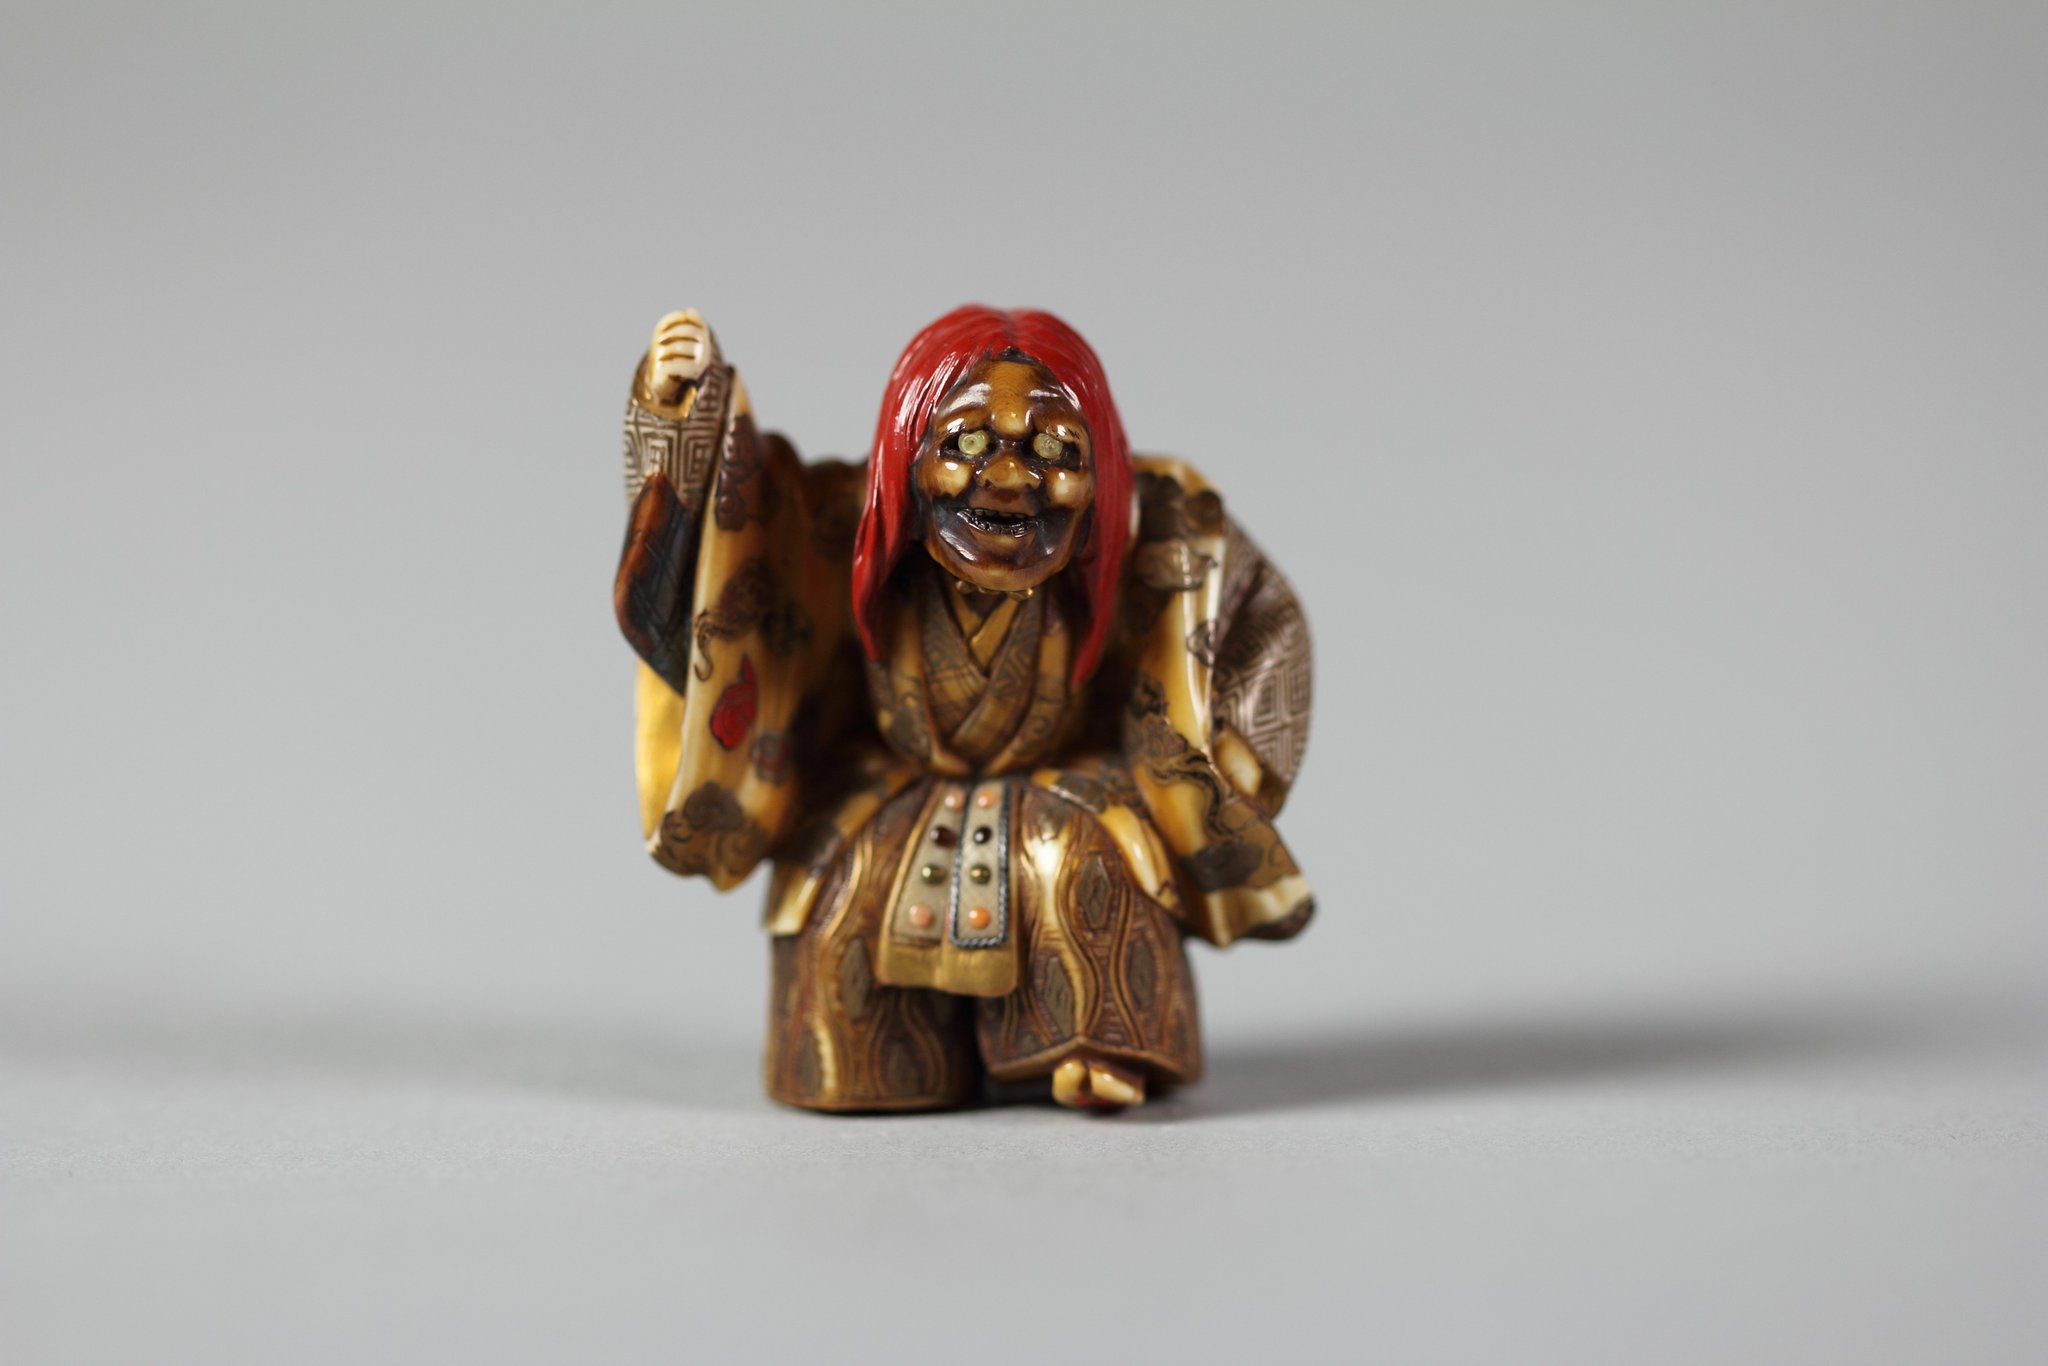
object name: netsuke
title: Netsuke of Noh Dancer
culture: japanese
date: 1801-1900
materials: ivory, lacquer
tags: dancers